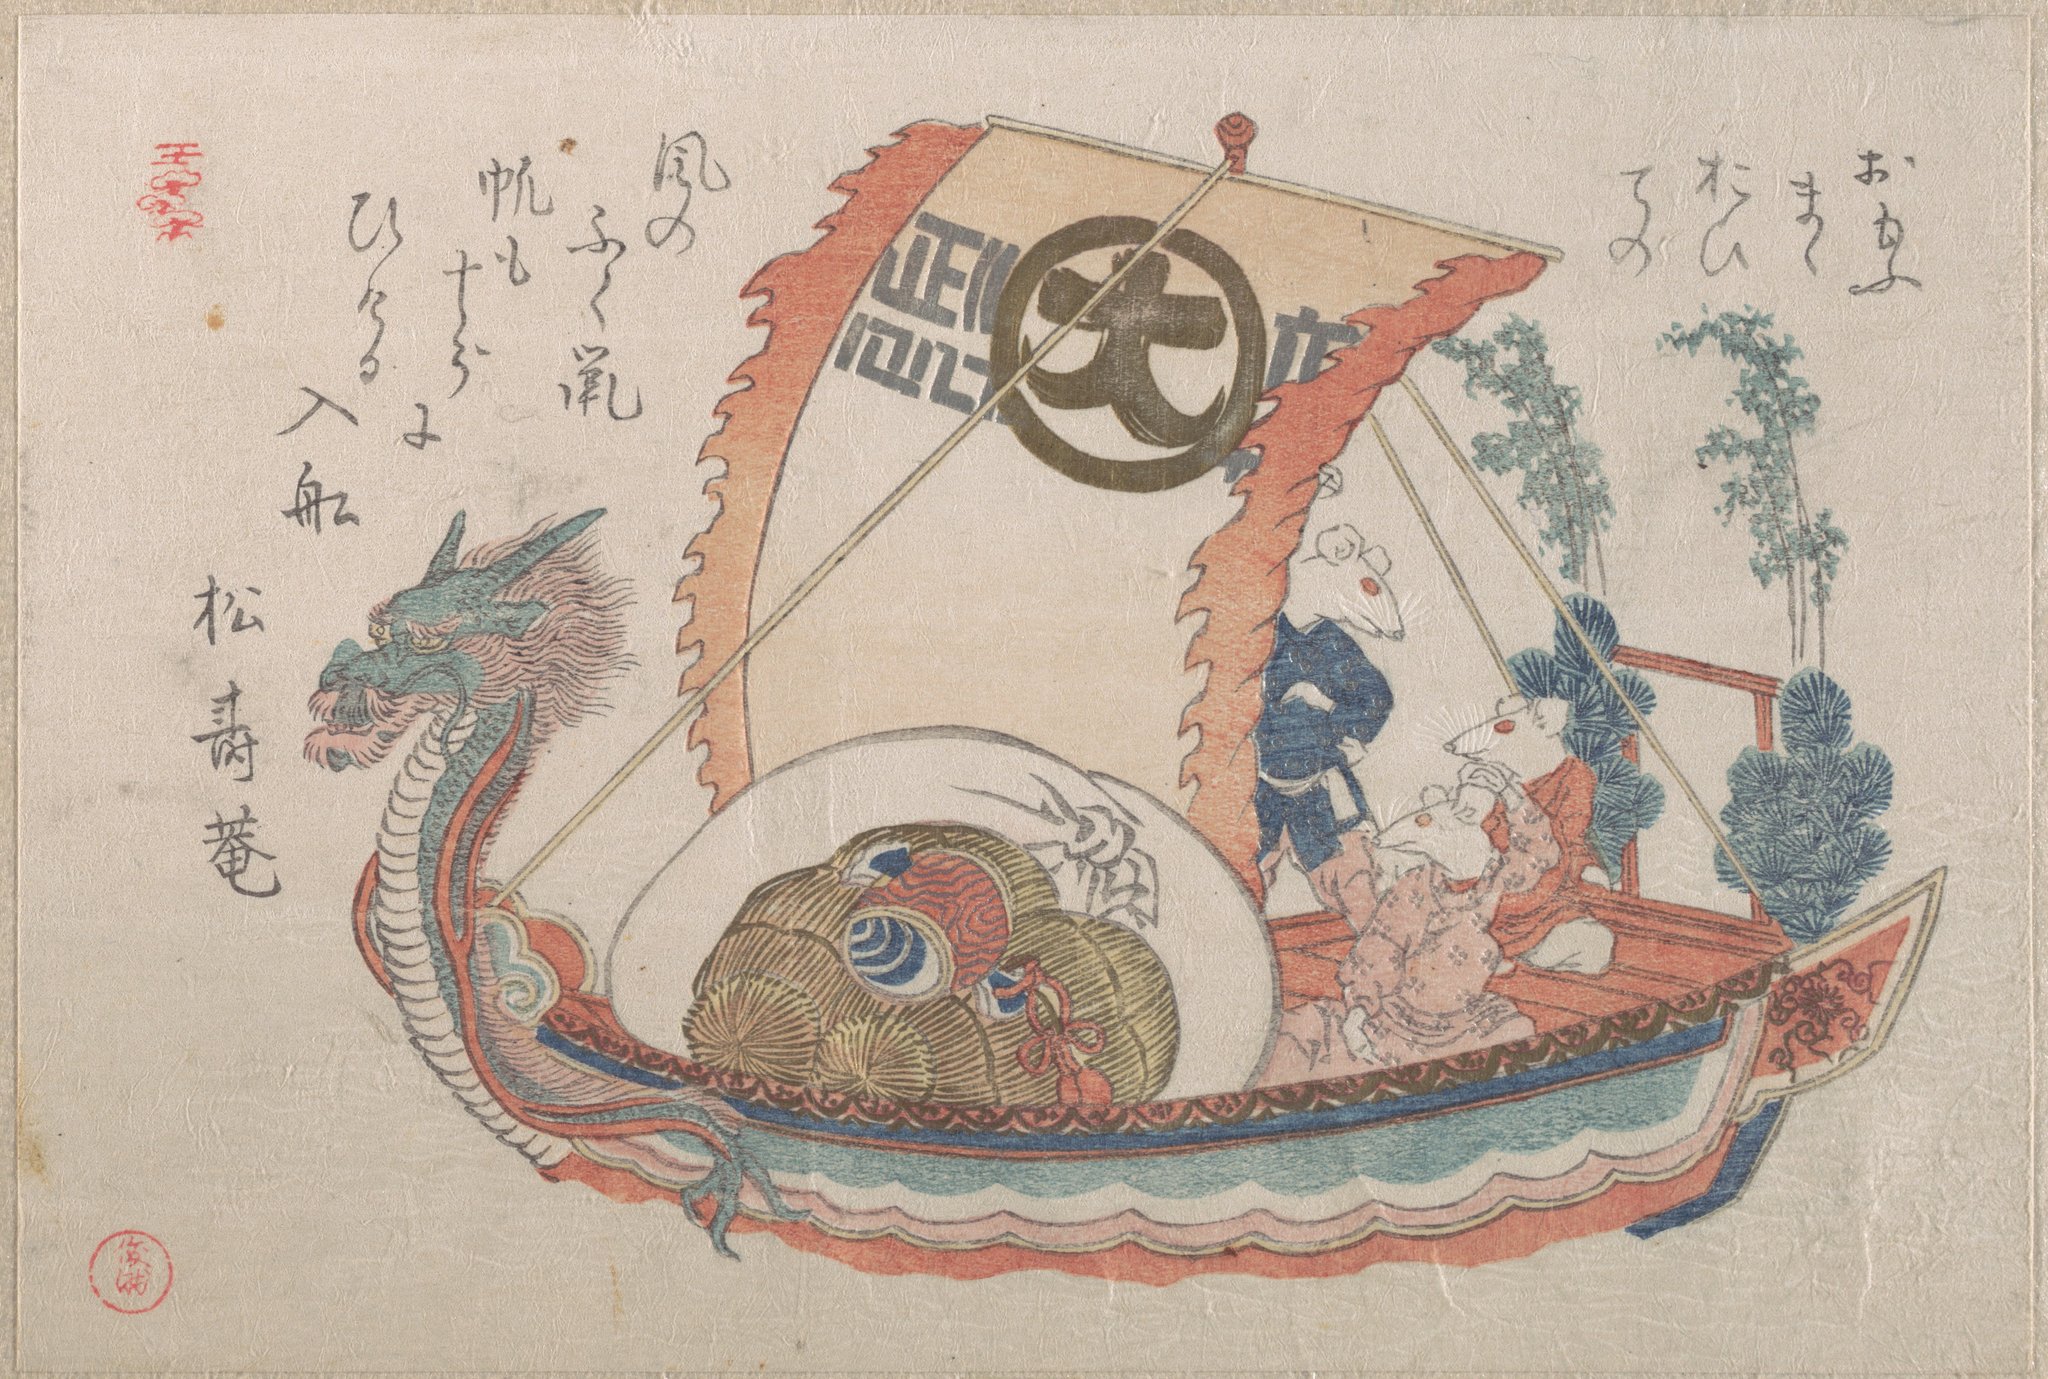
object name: print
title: Treasure Boat (Takara-bune) with Three Rats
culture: japanese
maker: kubo shunman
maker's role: artist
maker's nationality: japanese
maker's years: 1757-1820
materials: ink, paper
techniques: surimono, woodblock print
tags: animals,dragons,boats